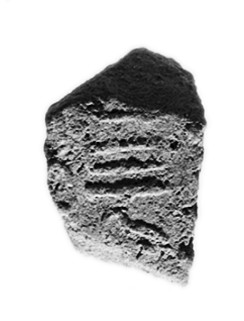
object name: sealing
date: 1981-1640 BCE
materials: mud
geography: egypt